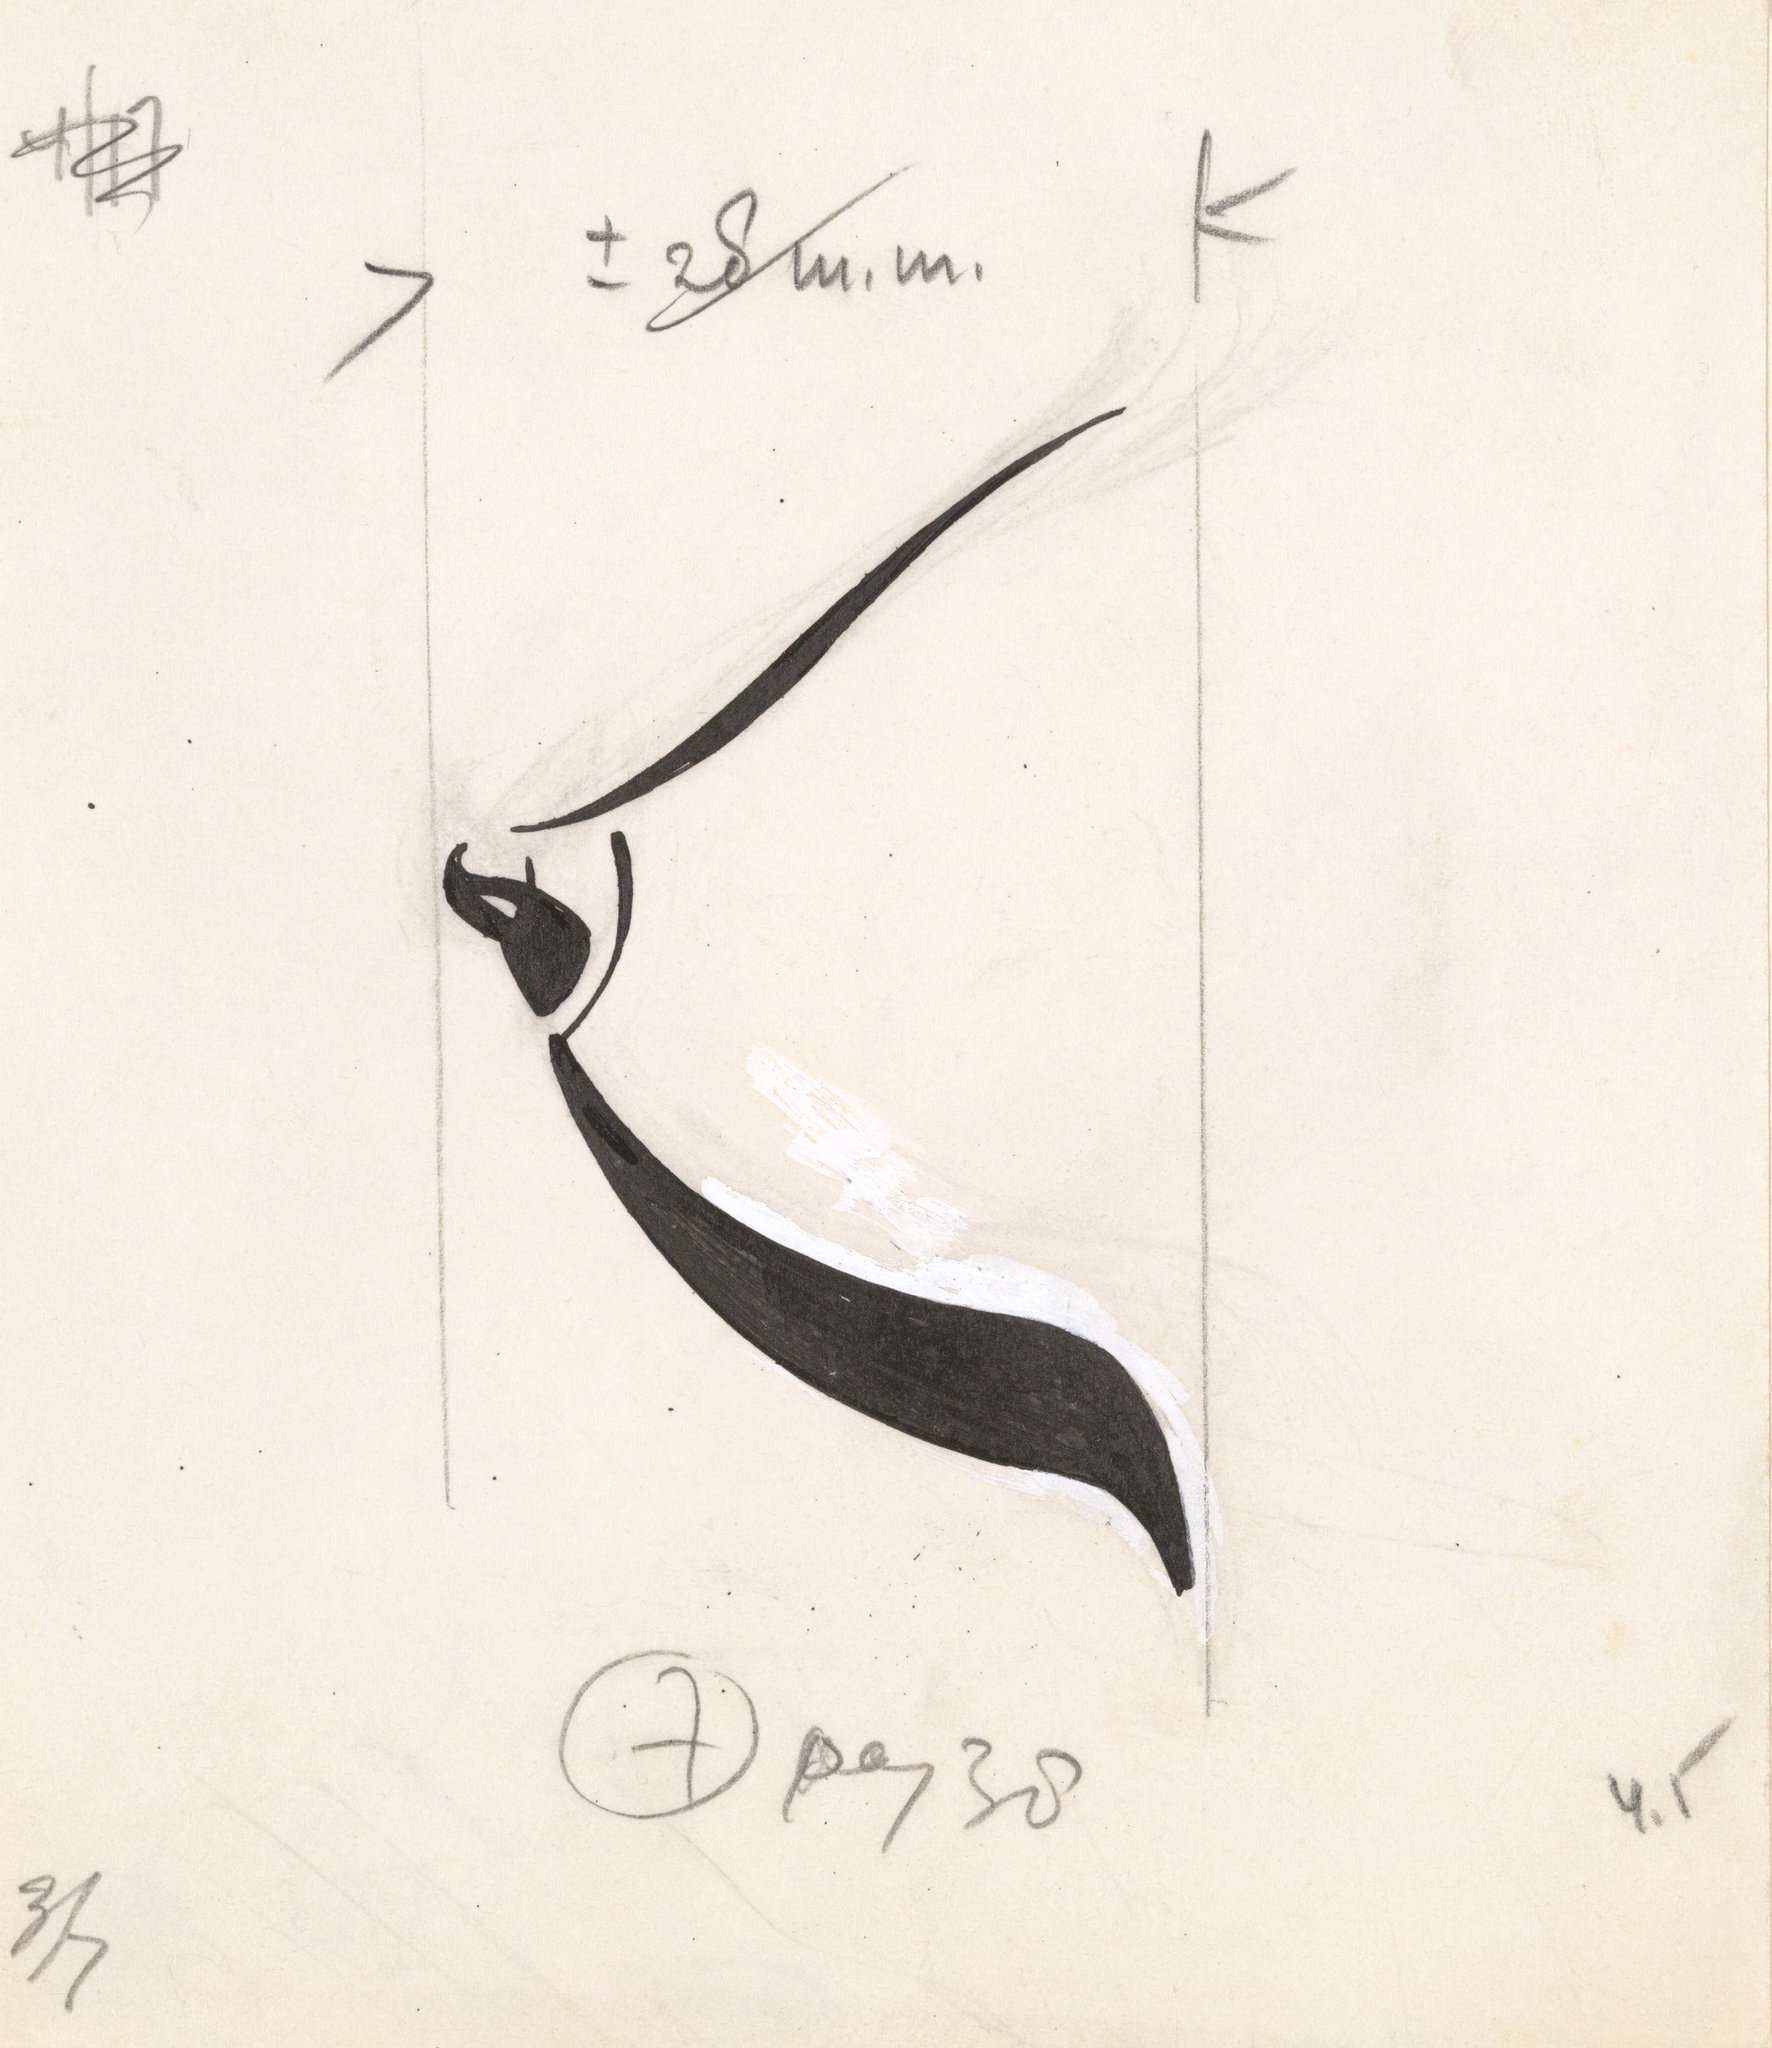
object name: drawing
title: Vrouwenborst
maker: hans borrebach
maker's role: draughtsman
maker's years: 1903-1991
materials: paint, ink, paper, pencil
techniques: brush, pen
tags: breasts - aa - female human figure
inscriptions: collector's mark: Lugt 2228a, :, annotation: ‘7 pag 38’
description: Ontwerp voor: Borrebach, Hans. Tekenen en schetsen als hobby. Amsterdam: Veen, 1961.